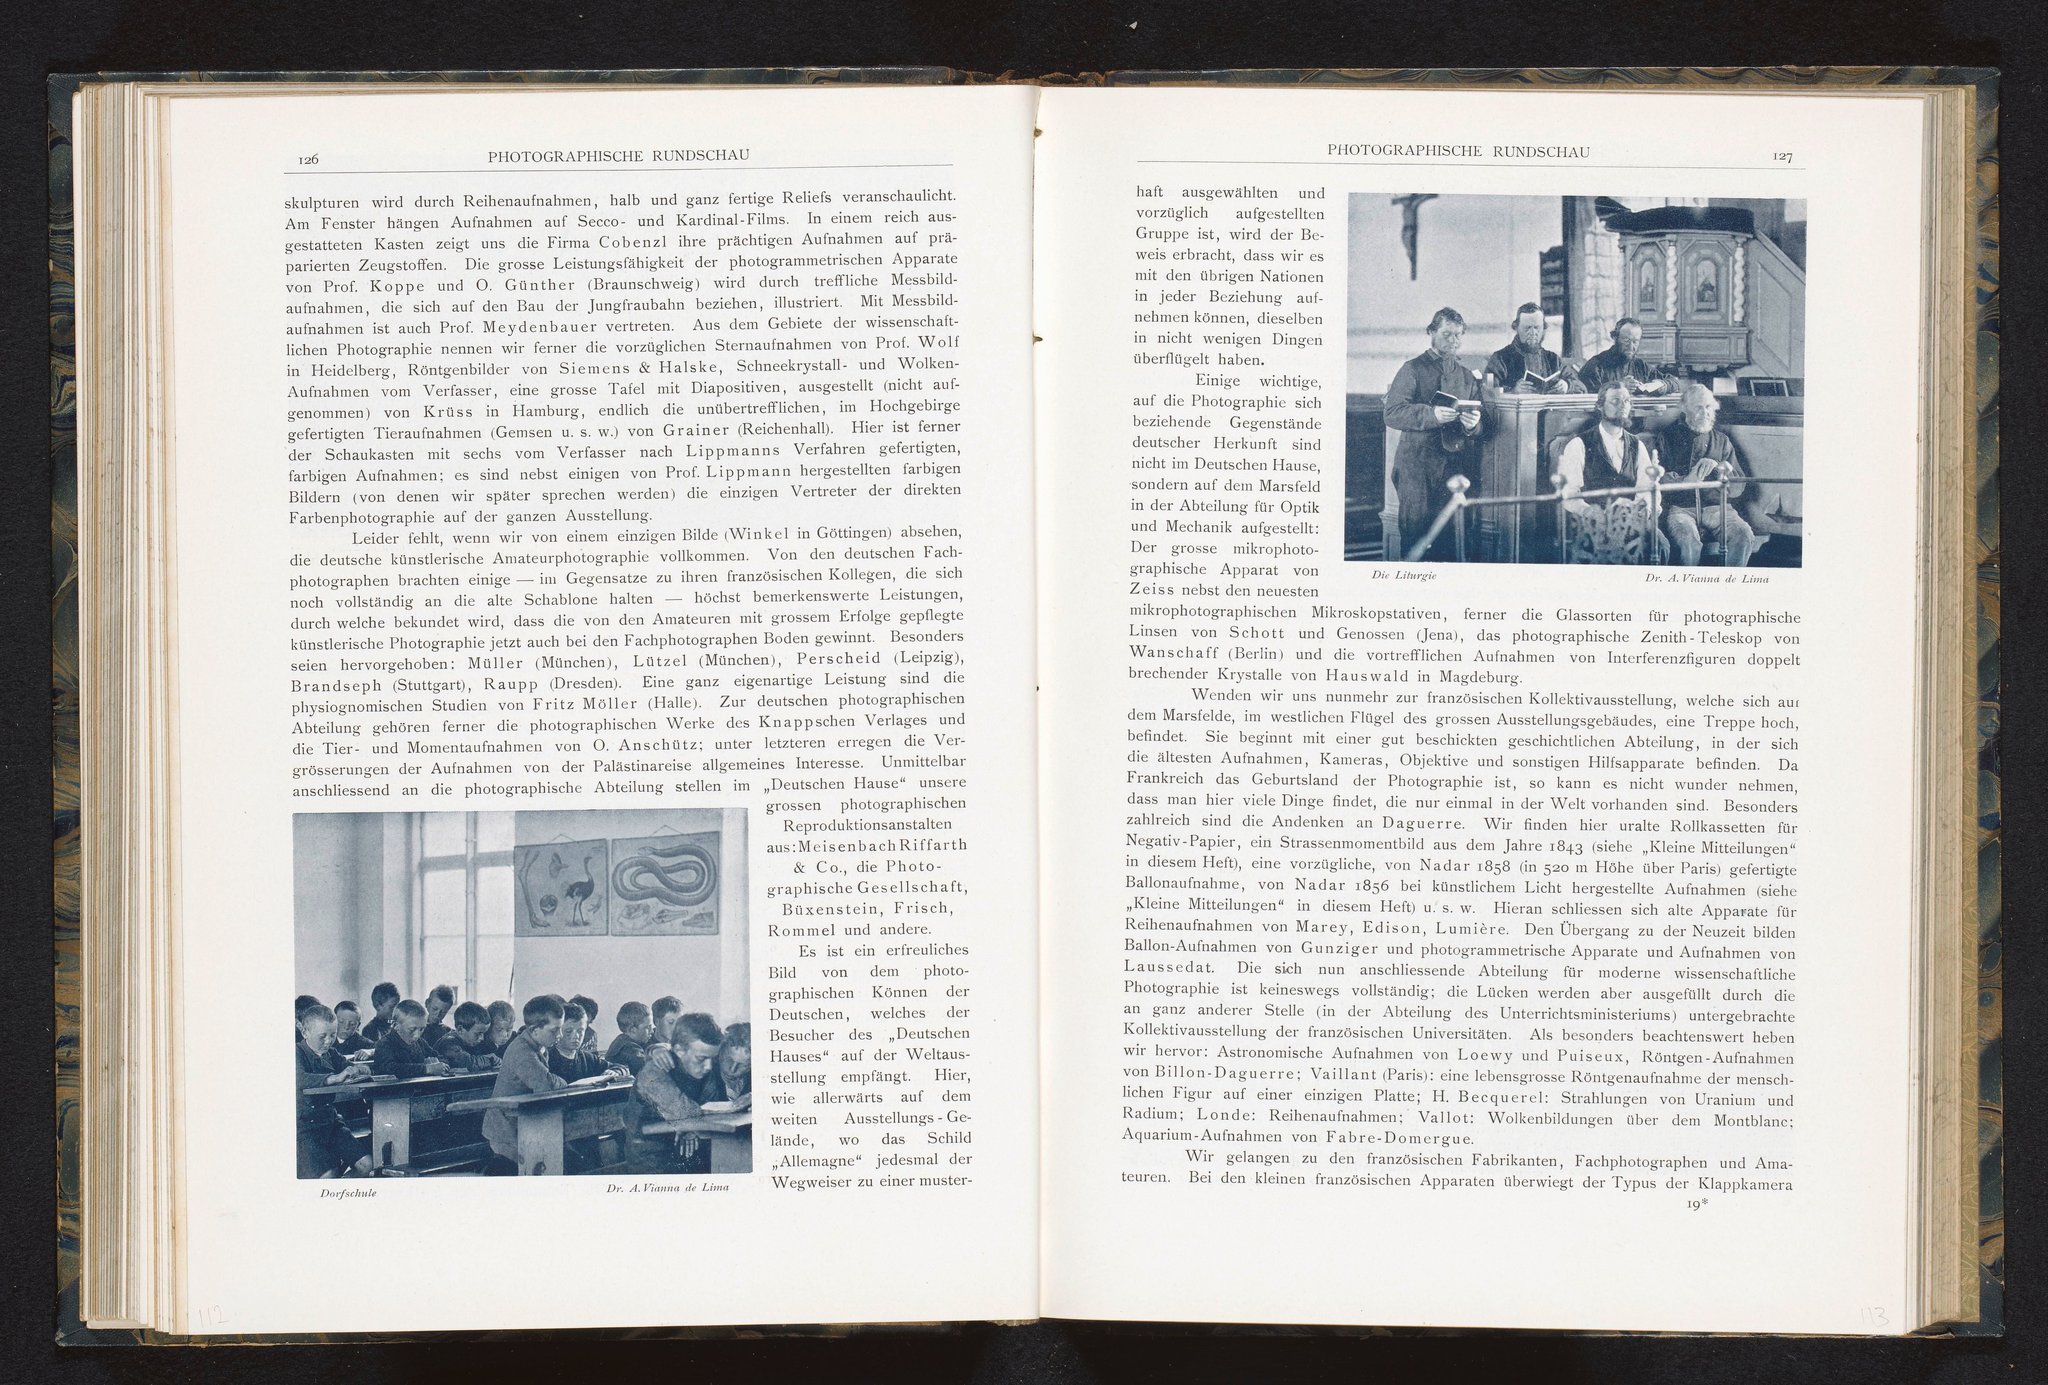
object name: photomechanical print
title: Dorfschule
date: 1895-1900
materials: paper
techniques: autotype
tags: elementary school; class, form